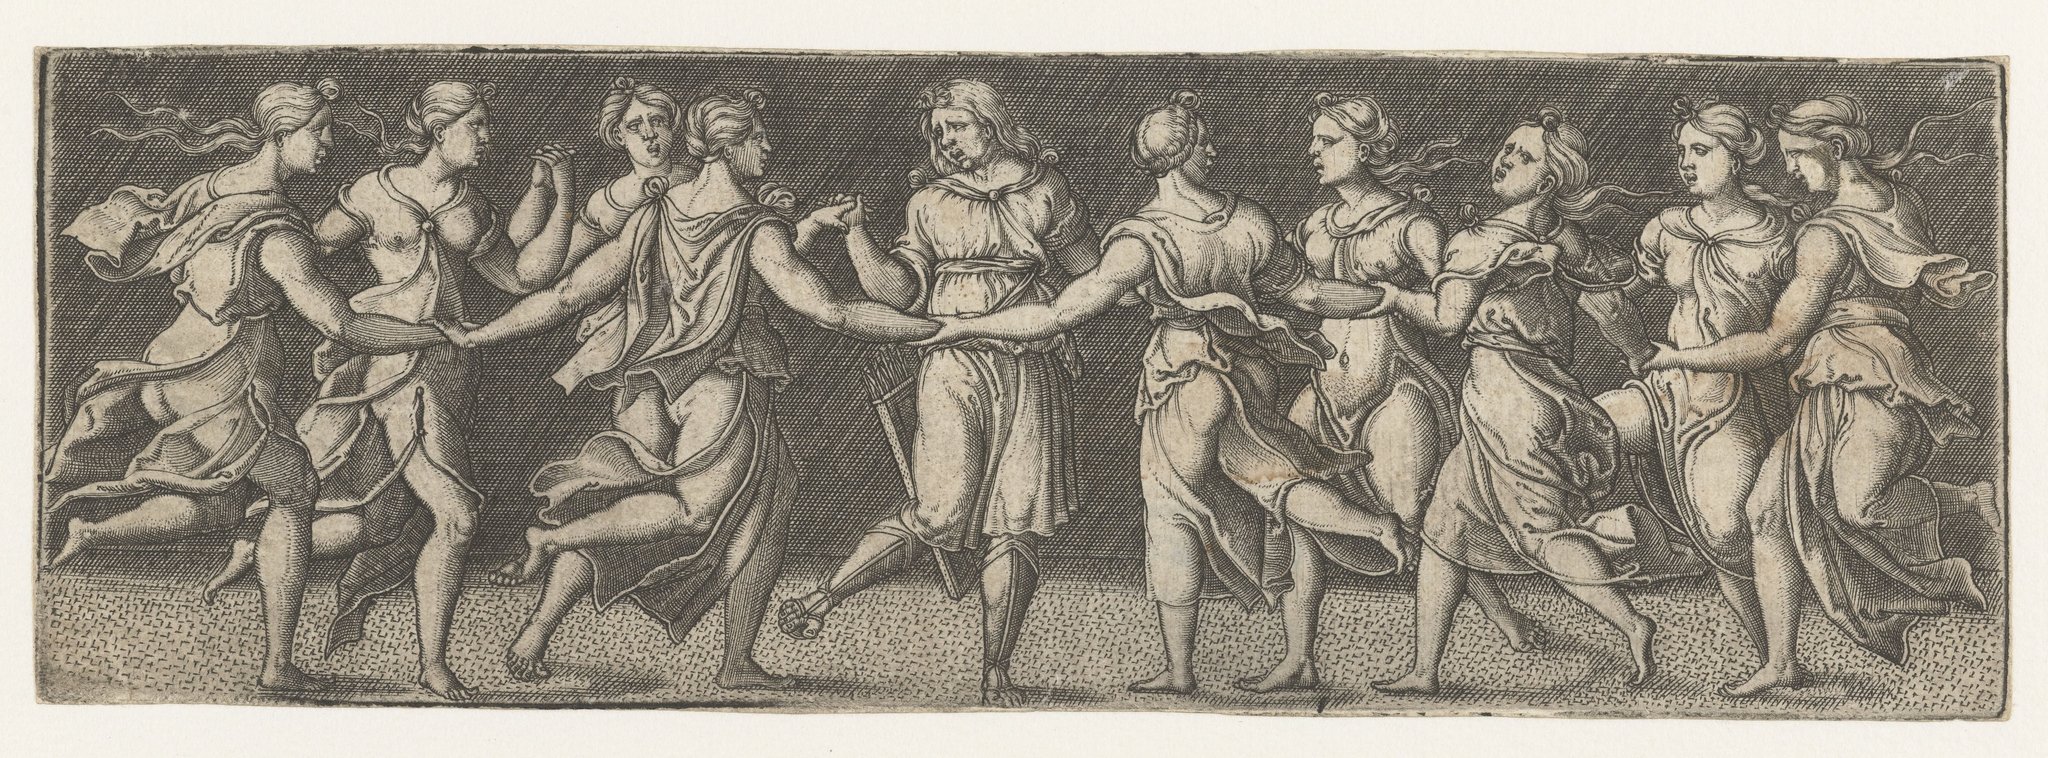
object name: print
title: Apollo en de Muzen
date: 1520-1562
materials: paper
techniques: engraving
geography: low countries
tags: apollo and the muses, apollo musagetes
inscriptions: collector's mark: Lugt 2228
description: De negen Muzen en Apollo doen een rondedans. Apollo met pijlkoker op de rechterdij.